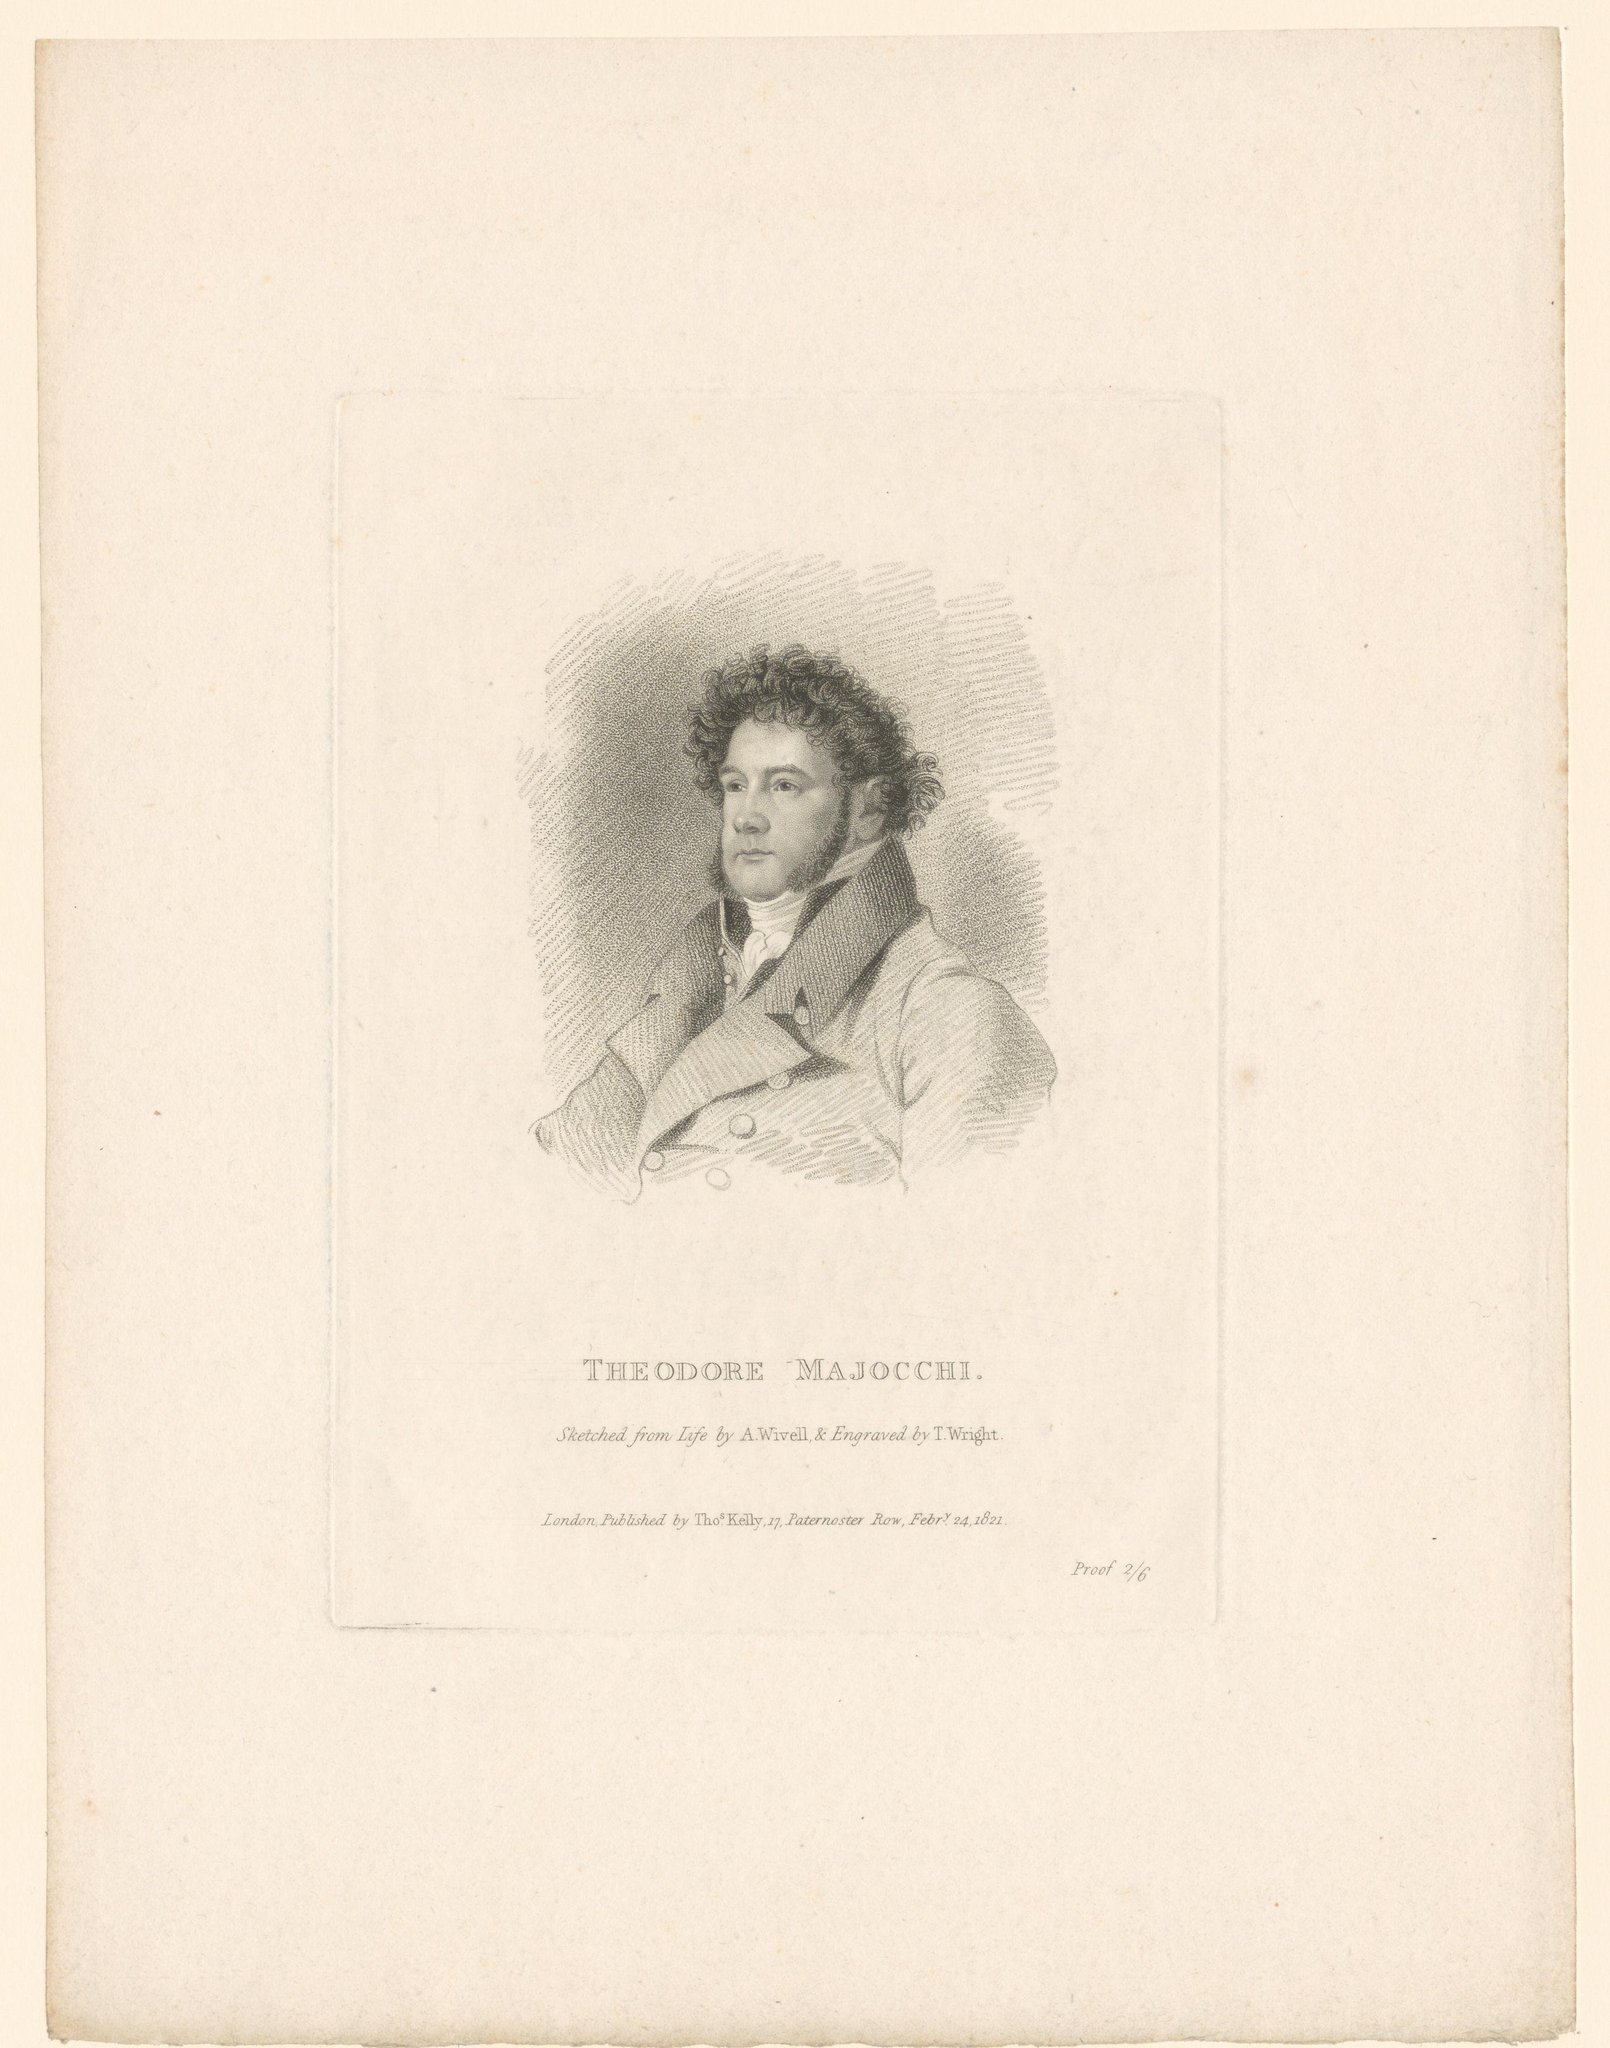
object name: print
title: Portret van Theodore Majocchi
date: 1821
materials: paper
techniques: printmaking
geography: london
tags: historical persons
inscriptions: : ‘Proof 2/6’, collector's mark: Lugt 2228